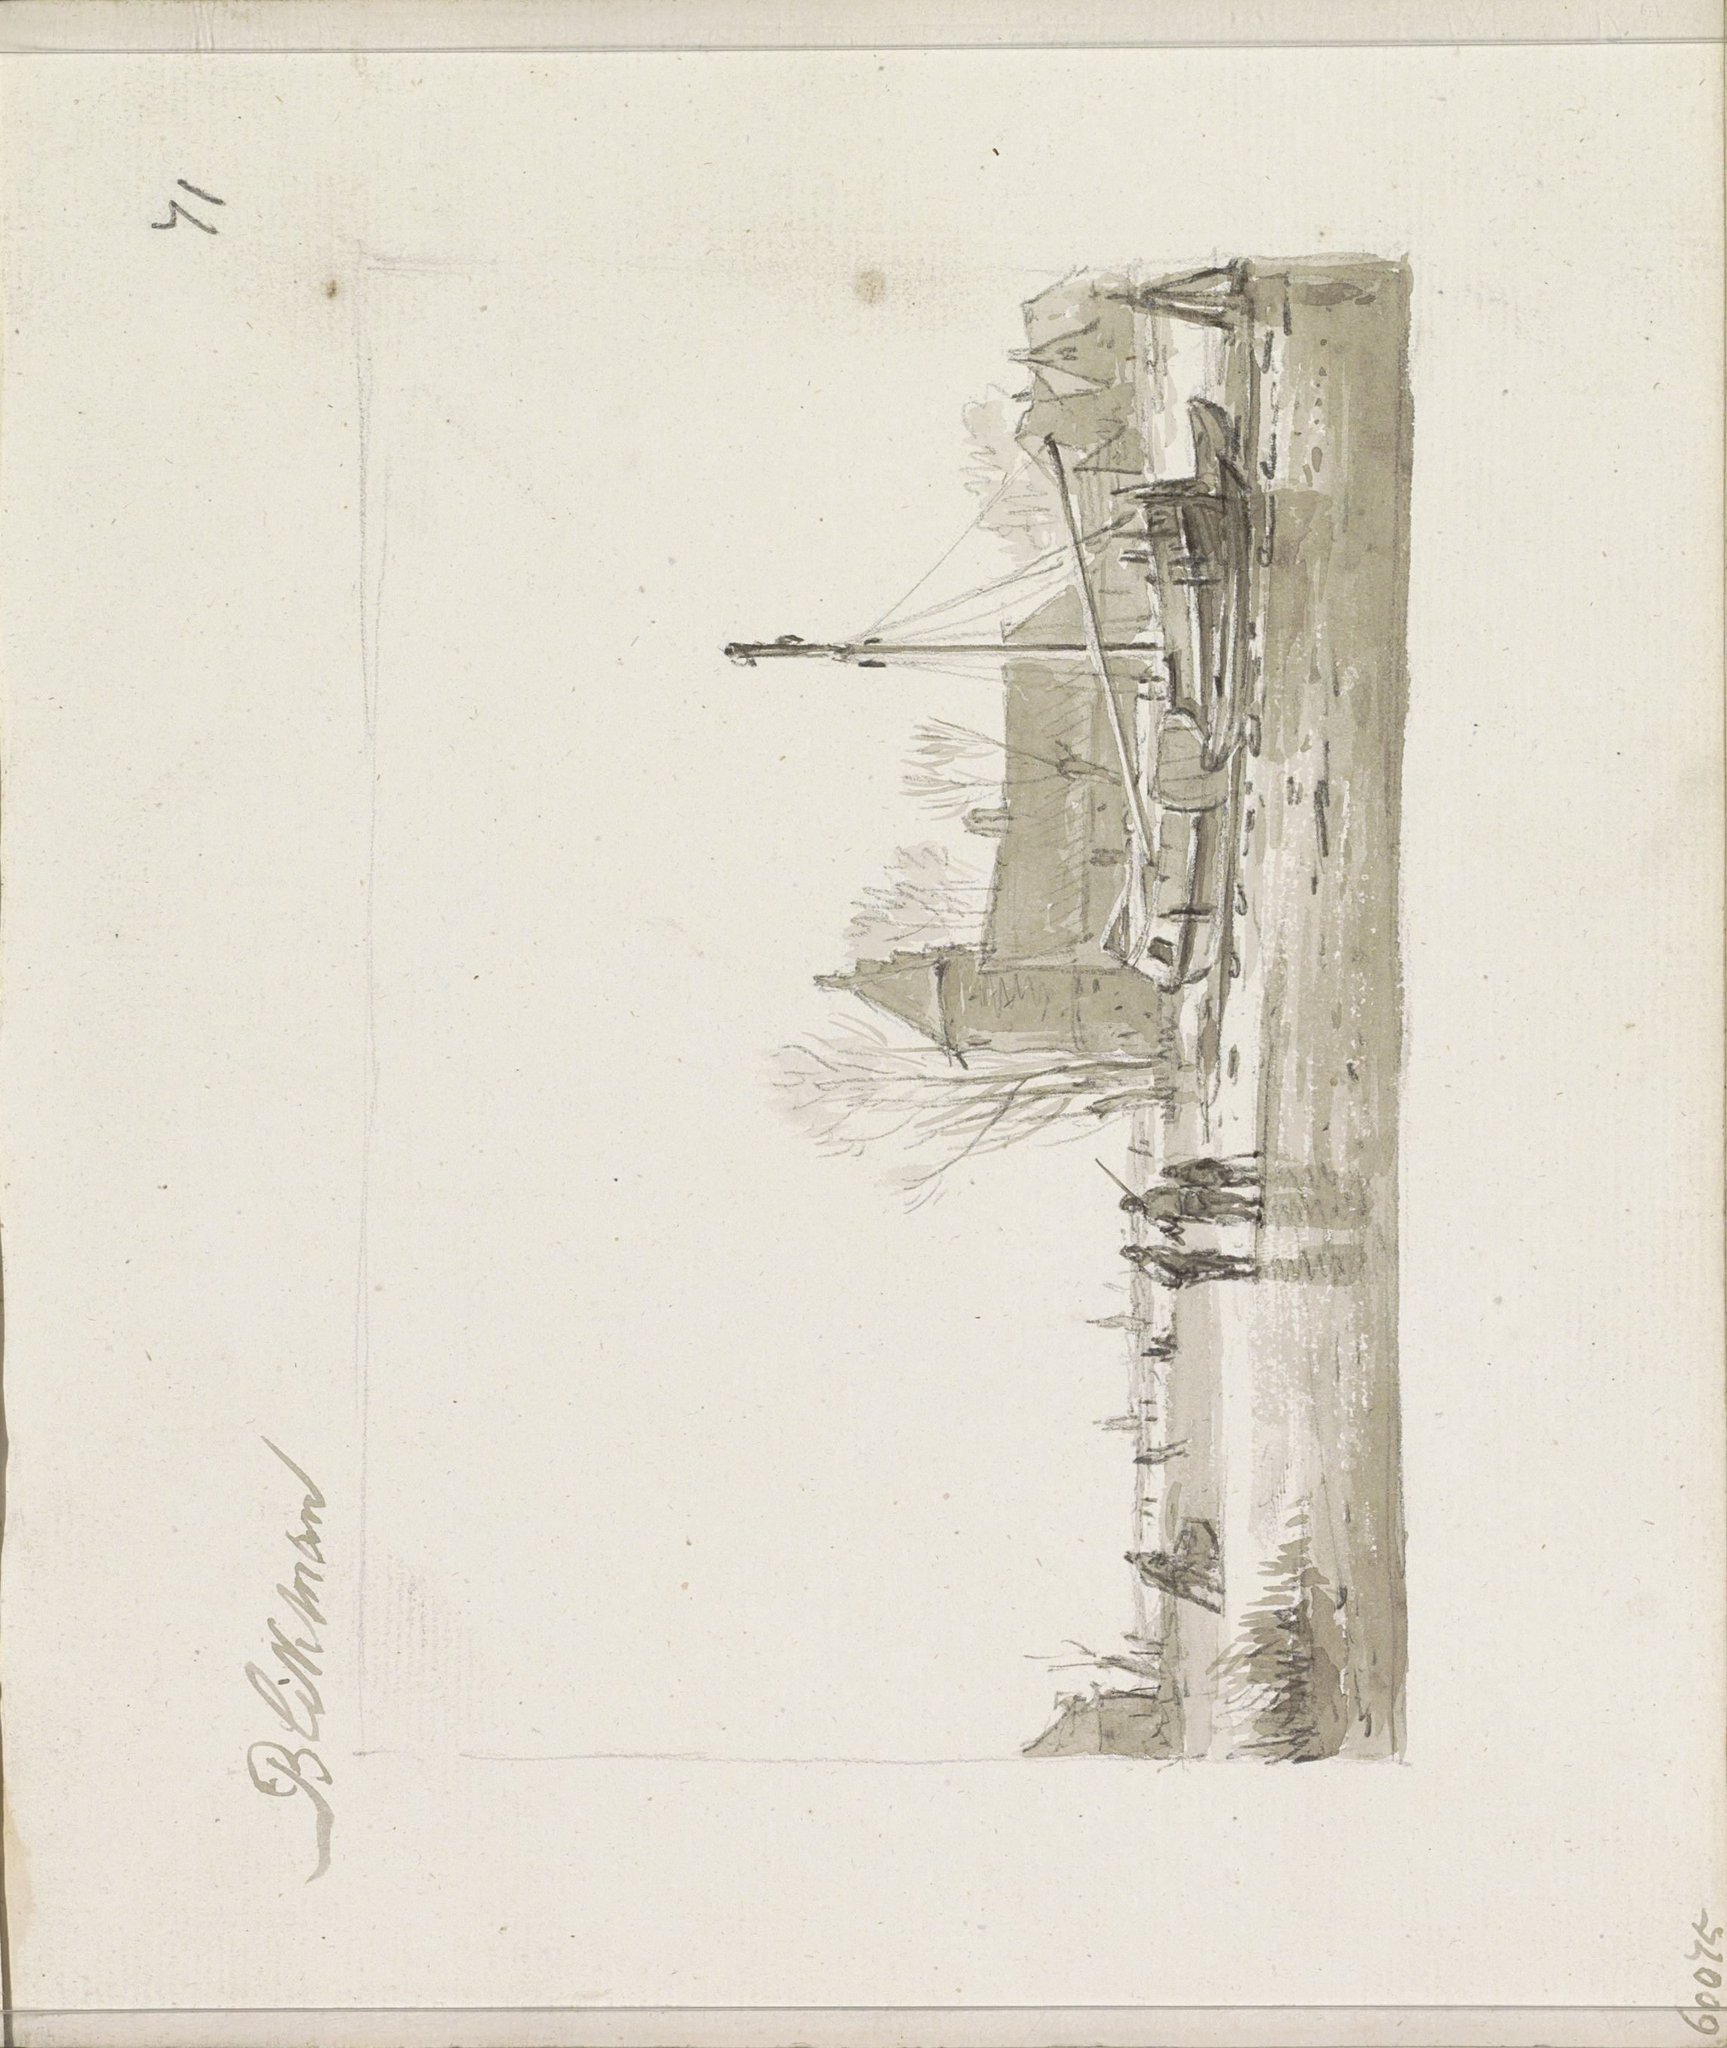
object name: sketchbook leaf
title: Winterlandschap met figuren op een bevroren vaart bij de vestingtoren van Delft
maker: andreas schelfhout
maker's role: draughtsman, painter, print maker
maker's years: 1787-1870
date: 1825-1828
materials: paper, pencil, watercolor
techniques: brush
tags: frost, freezing weather, towers ~ fortified city, skates (winter sports), delft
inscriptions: annotation: ‘Blikman’, number: ‘71/ 60075’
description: Blad 86 recto uit een schetsboek met 95 bladen.